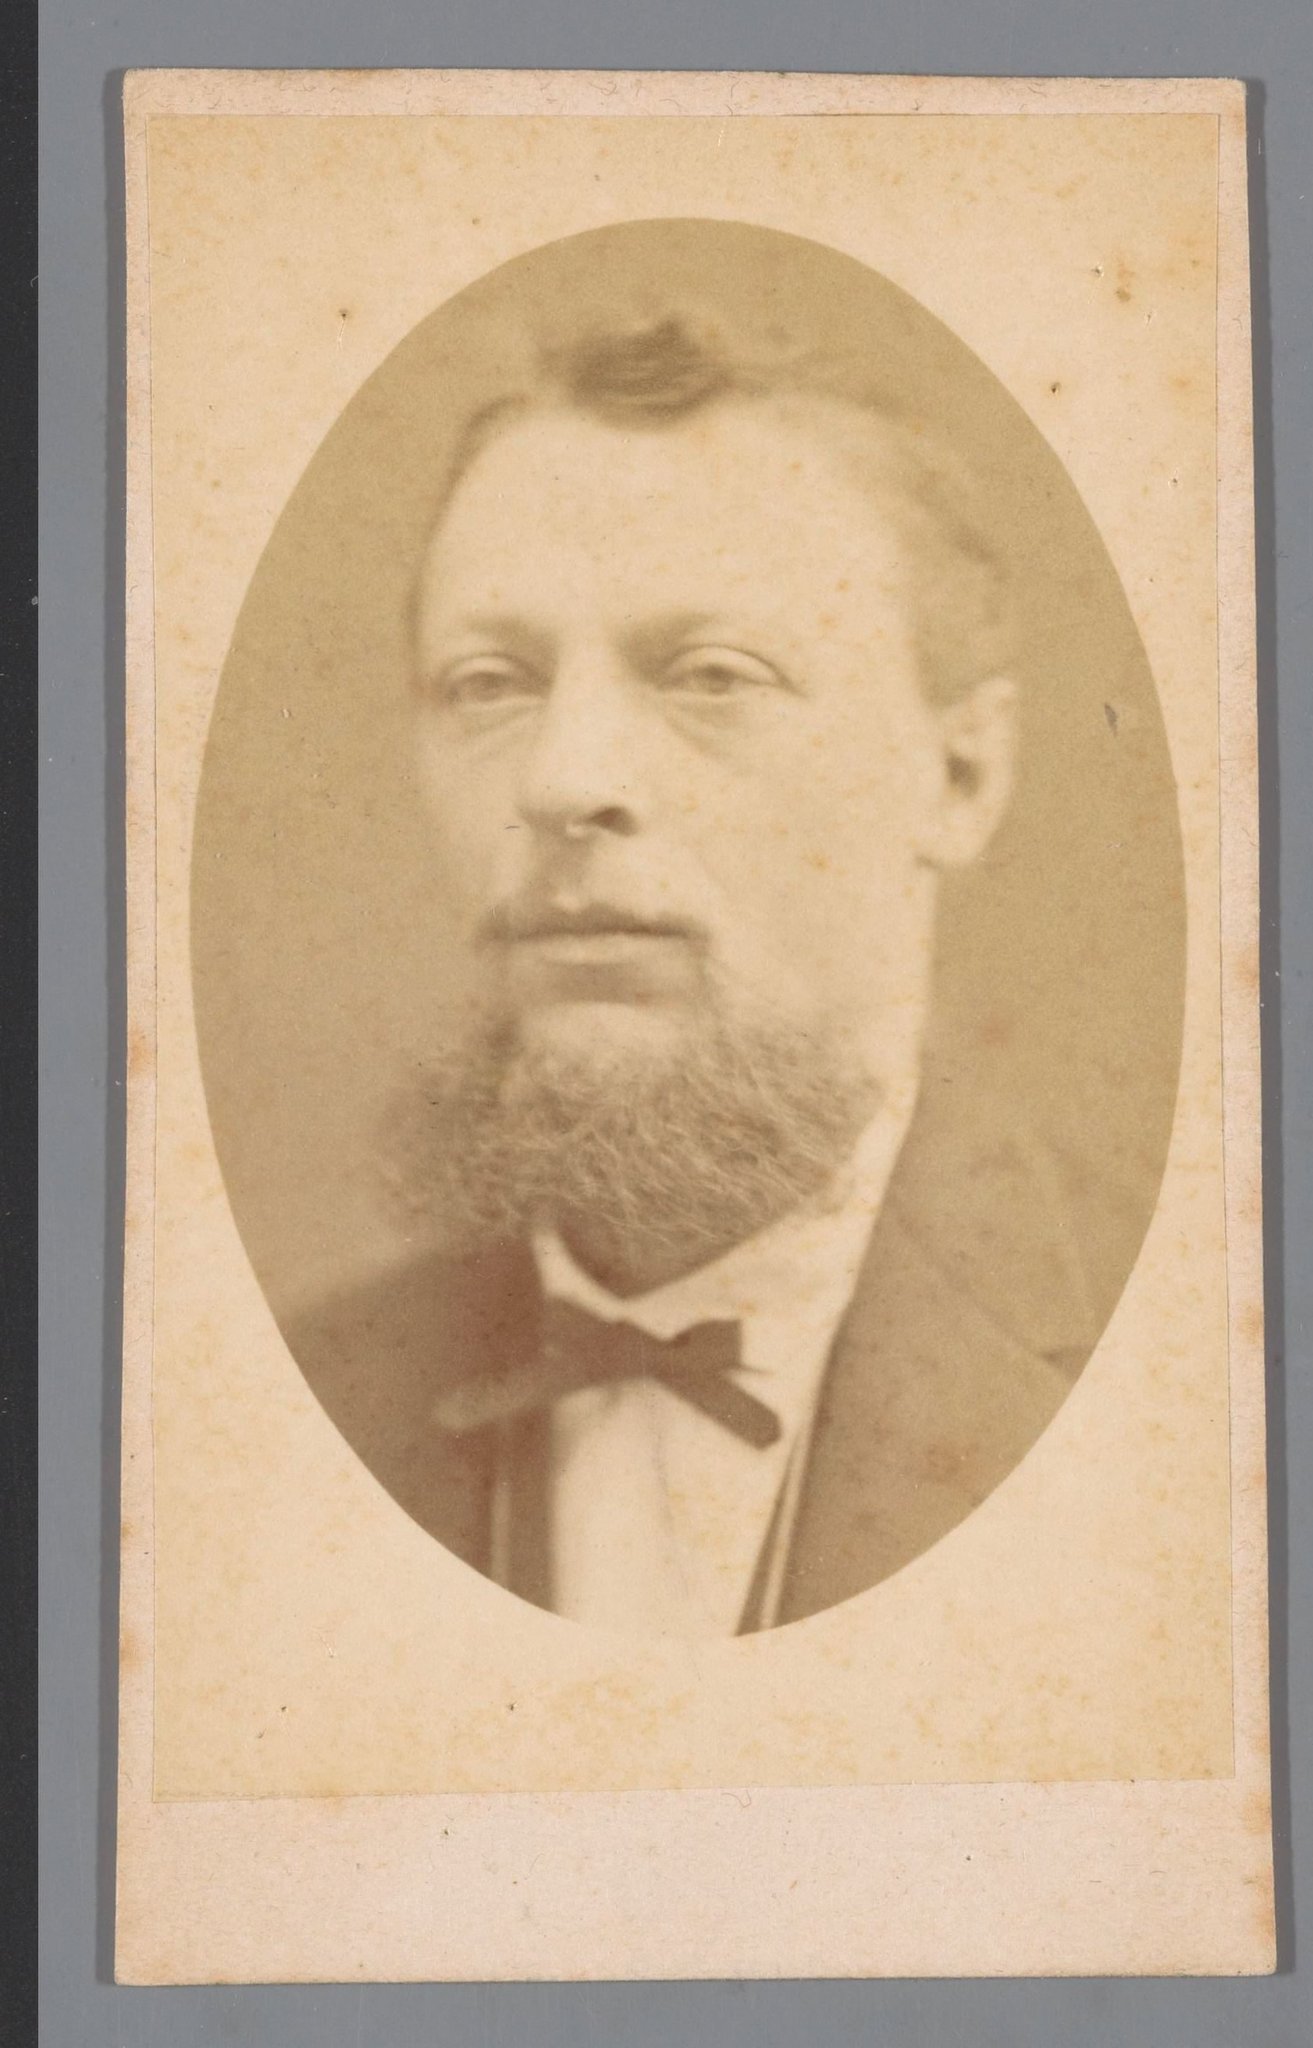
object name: photograph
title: Portret van een man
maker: hermanus siderius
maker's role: draughtsman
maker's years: 1819-1892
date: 1868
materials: cardboard, paper, photographic support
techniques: albumen print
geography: harlingen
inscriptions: address: ‘H. Siderius/Harlingen’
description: Kop van een man met een baard. In ovaal, zonder achtergrond.